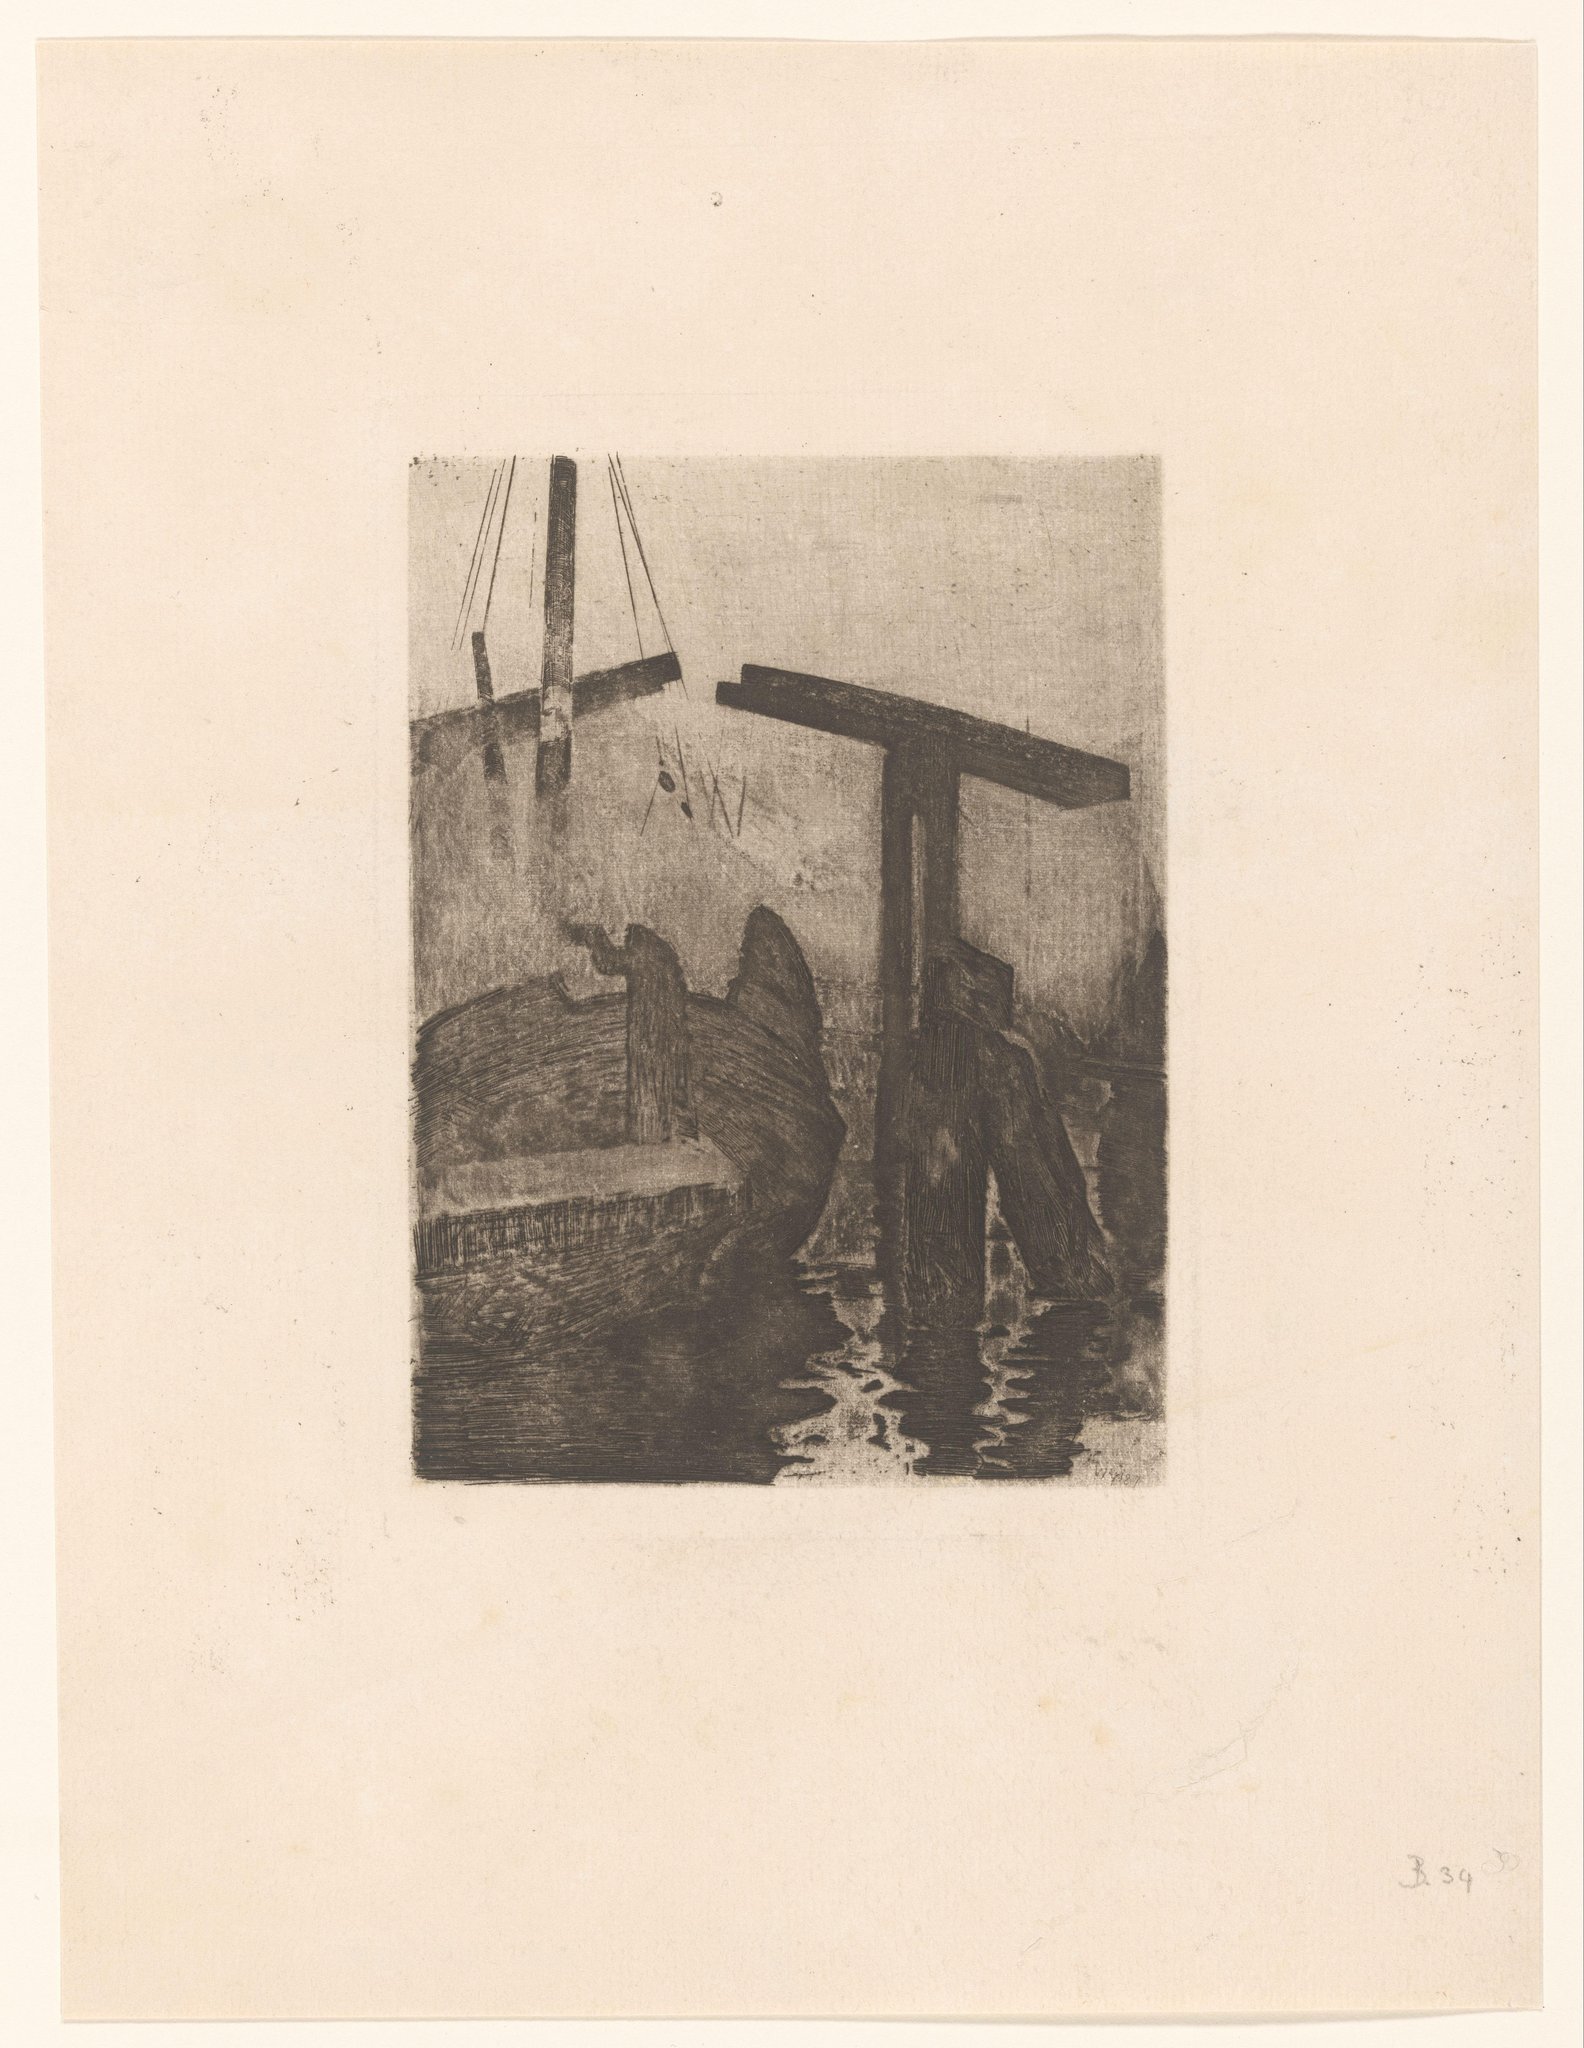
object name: print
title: Ophaalbrug en schip in de mist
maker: willem witsen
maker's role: draughtsman, painter, print maker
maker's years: 1860-1923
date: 1887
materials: paper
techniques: etching, intaglio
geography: amsterdam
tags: drawbridge ~ fortified city, ships (in general), amsterdam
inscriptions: watermark